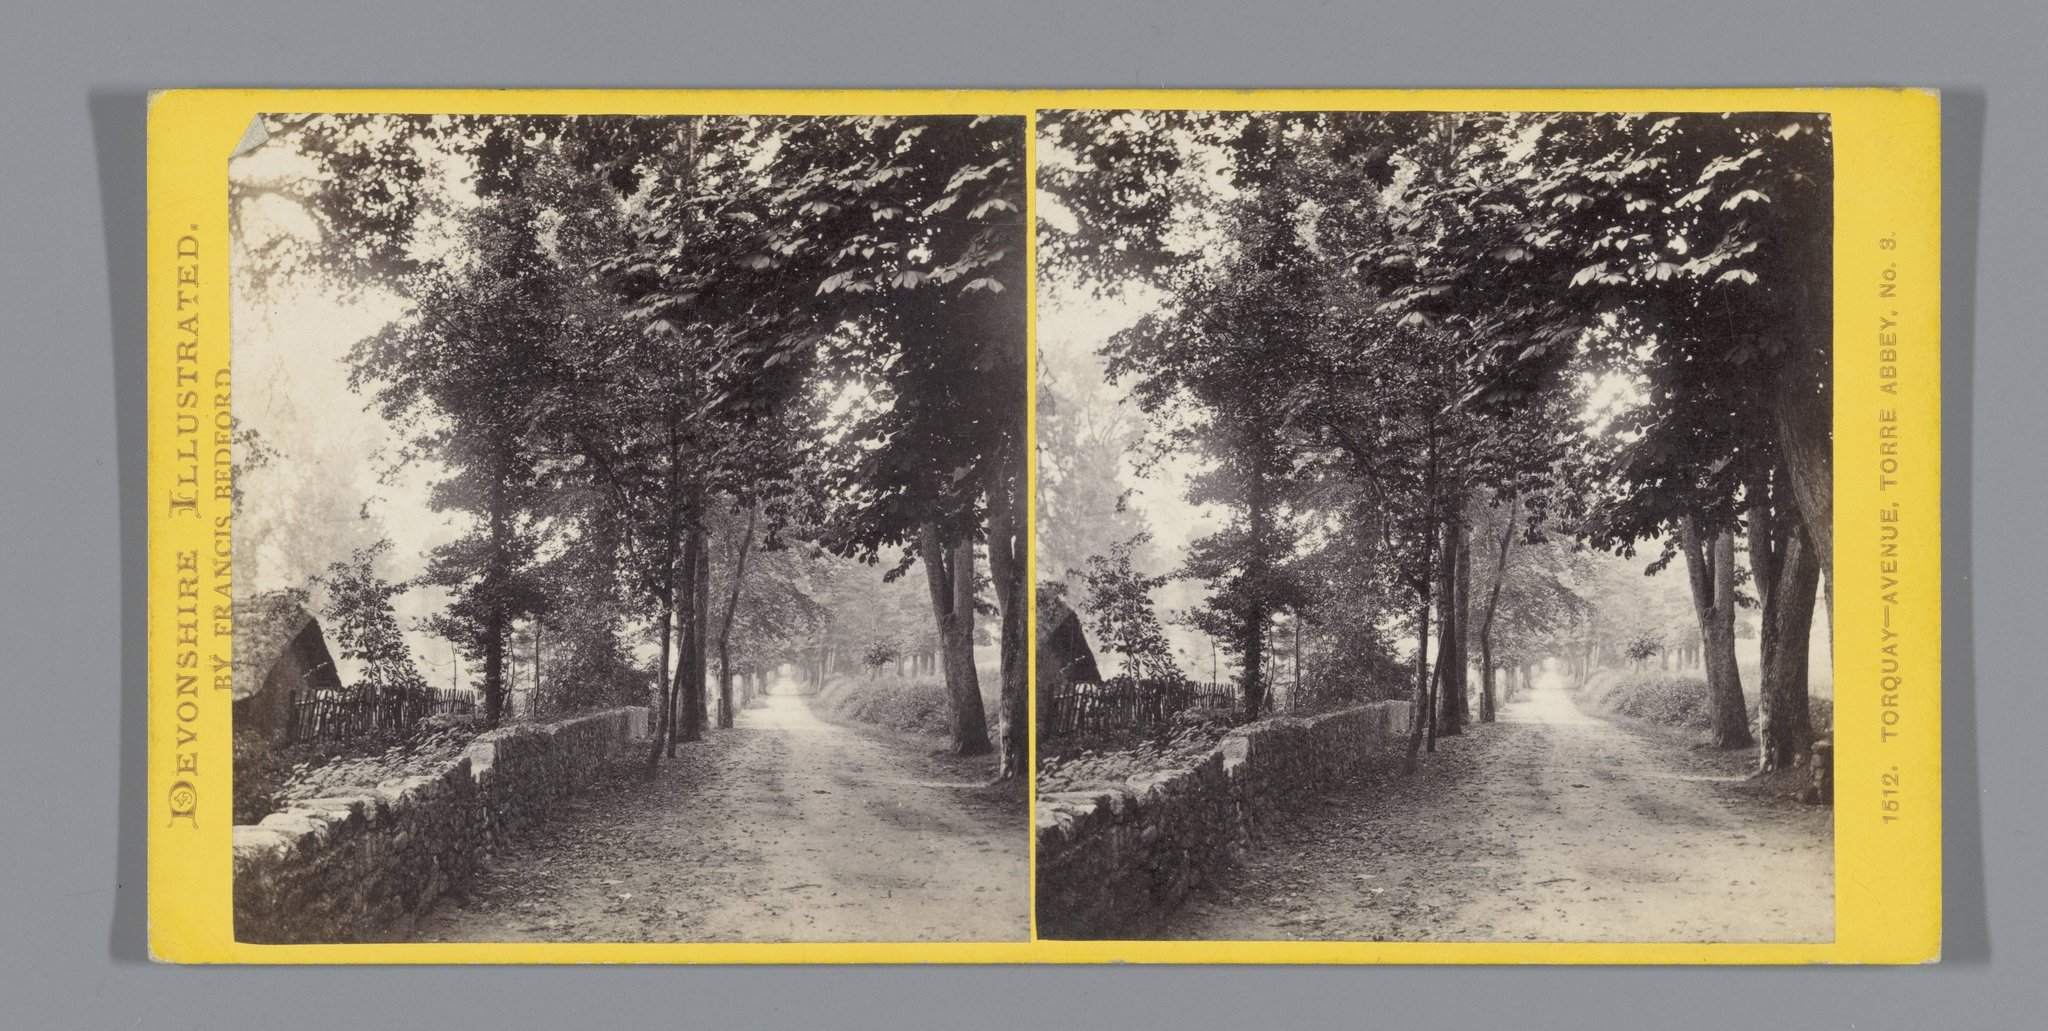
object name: stereograph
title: Toegangslaan van de Torre Abbey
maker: francis bedford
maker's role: print maker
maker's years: 1815-1894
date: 1850-1880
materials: cardboard, photographic support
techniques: albumen print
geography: devon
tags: lane, alley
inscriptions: inscription: ‘F.T.’, inscription: ‘Devonshire Illustrated. by Francis Bedford.’, number: ‘1512.’